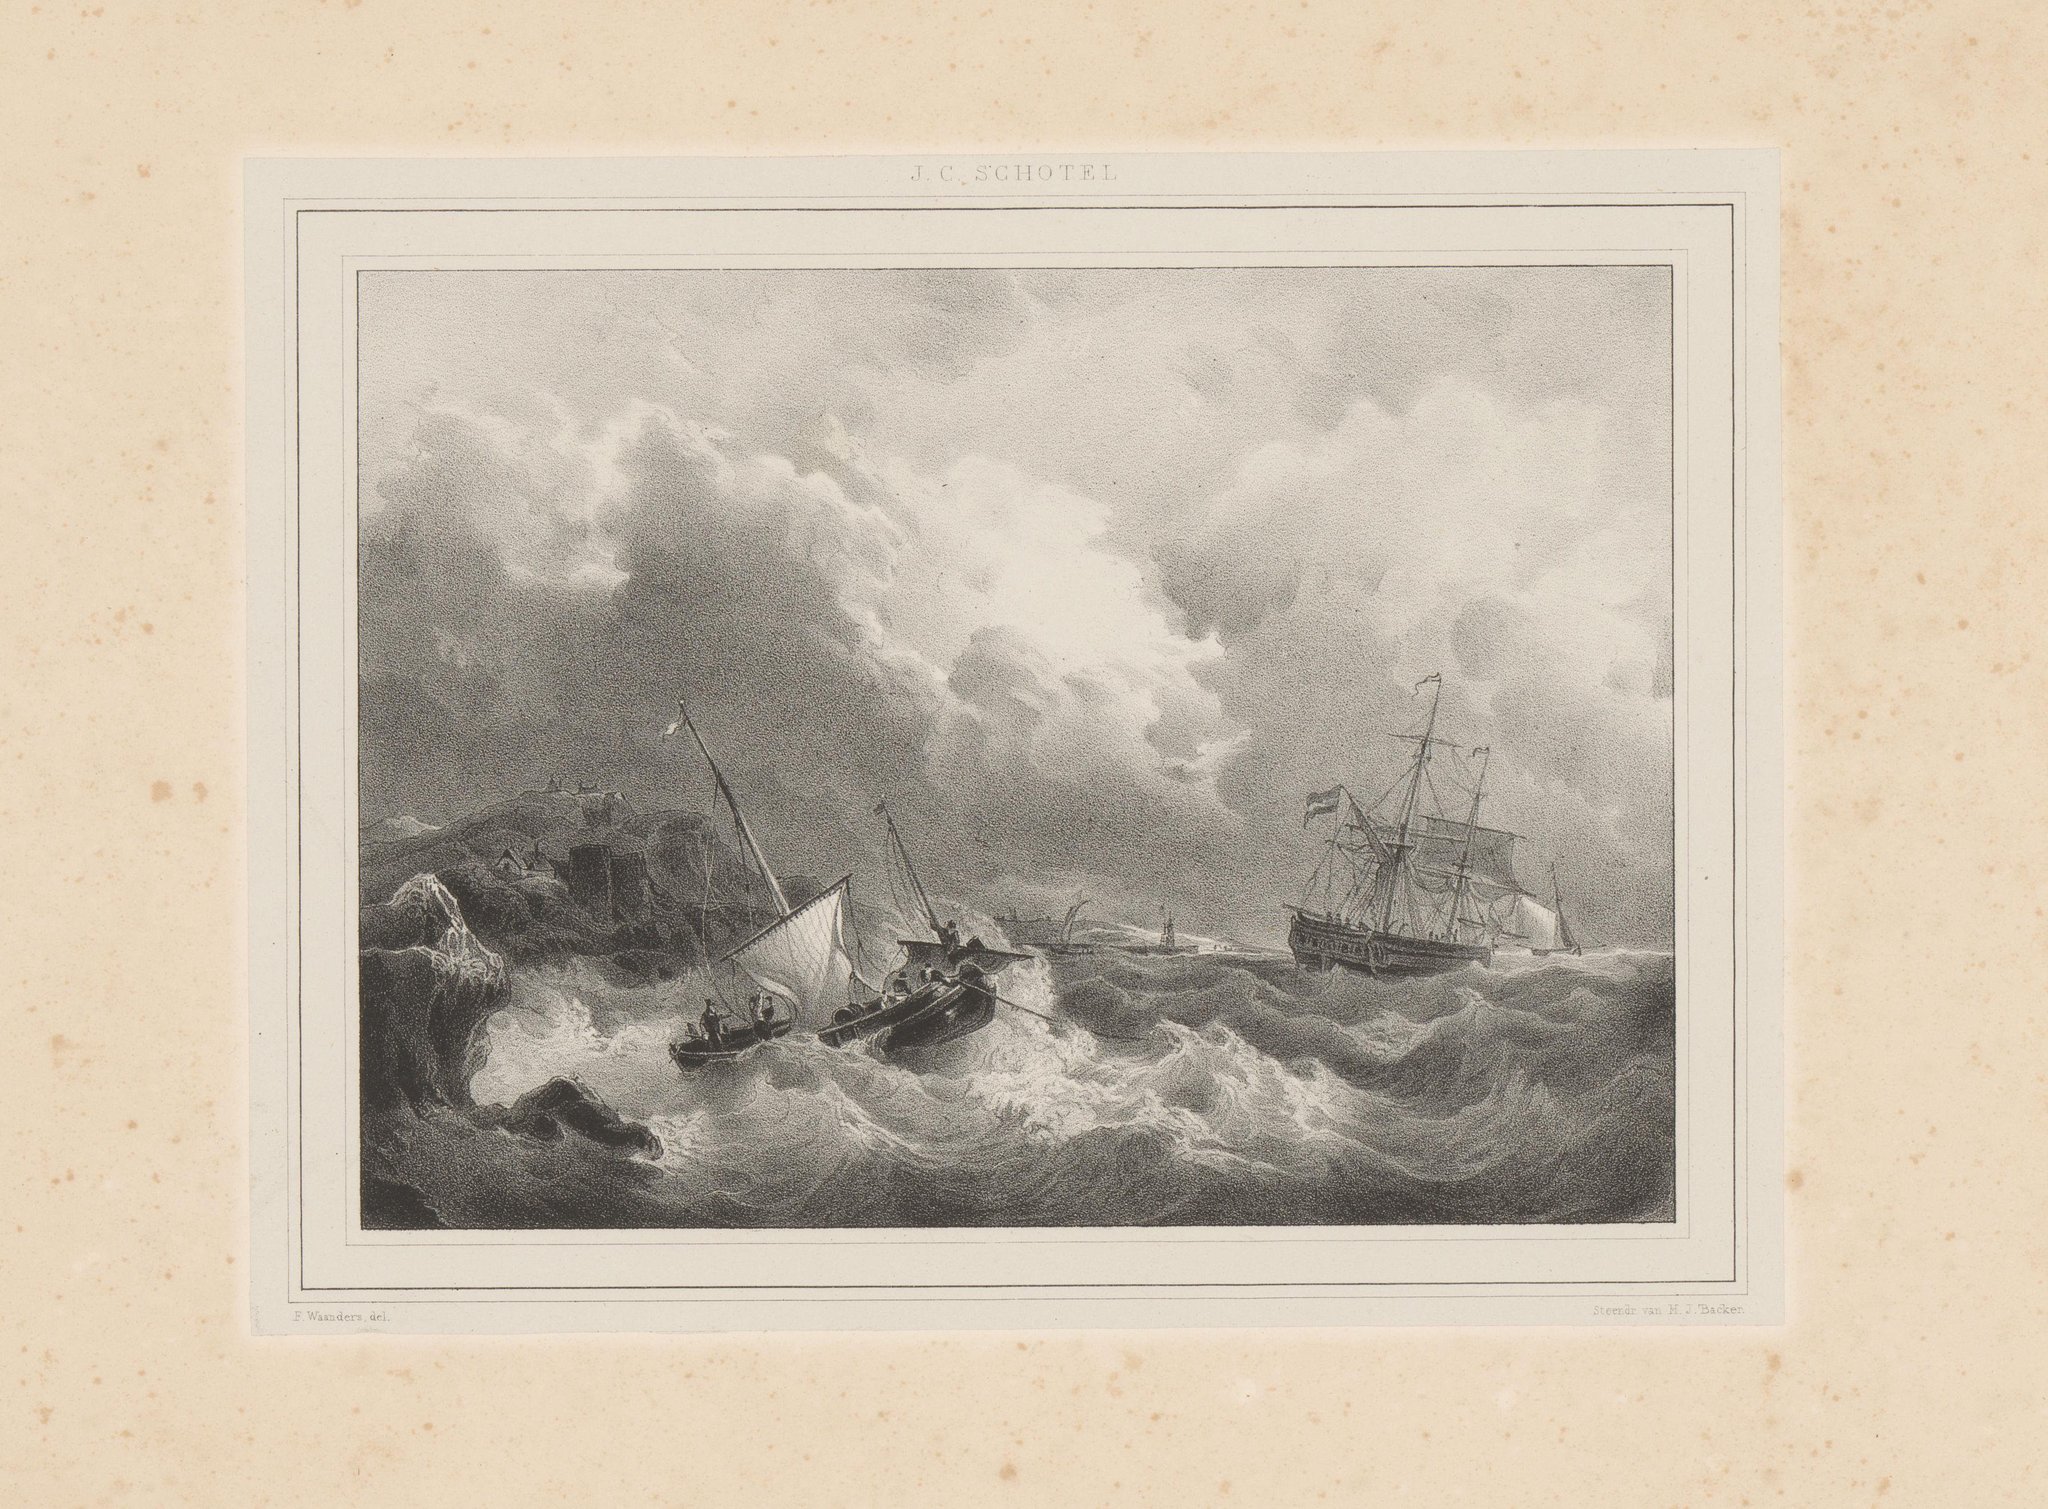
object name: print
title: Zeilschepen op stormachtige zee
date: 1822-1845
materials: paper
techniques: lithograph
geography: dordrecht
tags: sailing-ship, sailing-boat, storm at sea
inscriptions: collector's mark: Lugt 2760, collector's mark: Lugt 2228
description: Zeilboten en -schepen tijdens een storm op zee. Links een rotskust.